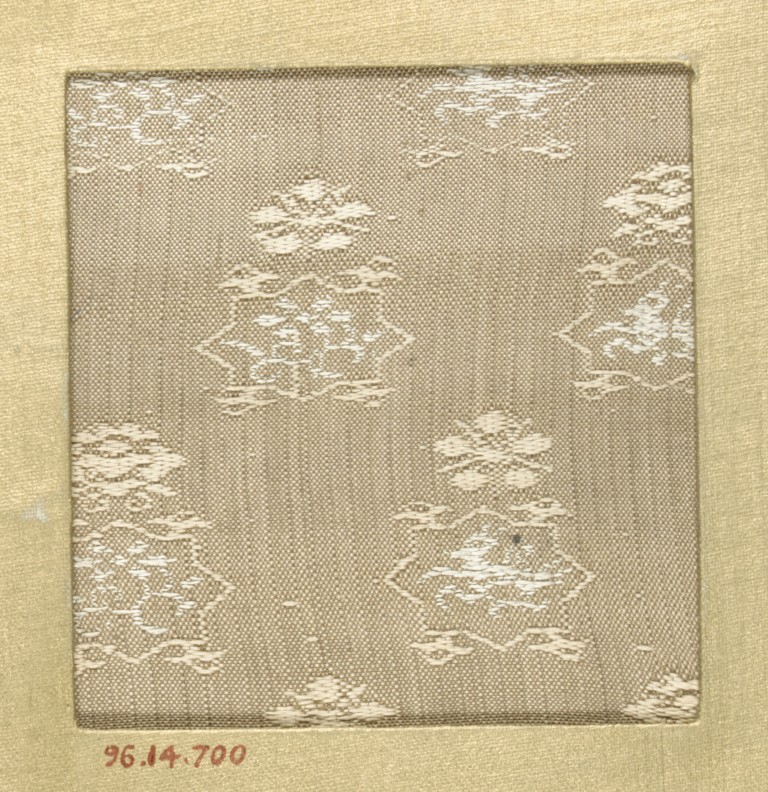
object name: piece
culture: japanese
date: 1701-1900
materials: silk